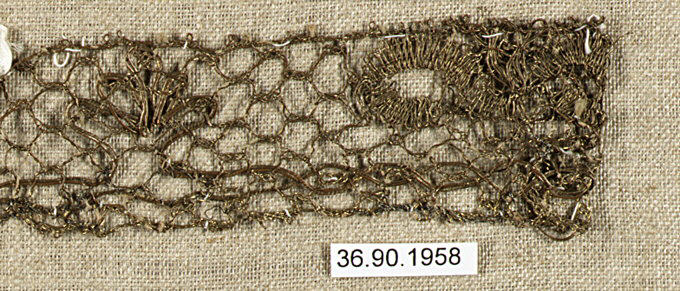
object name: piece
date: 1801-1900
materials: metal thread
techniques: lace